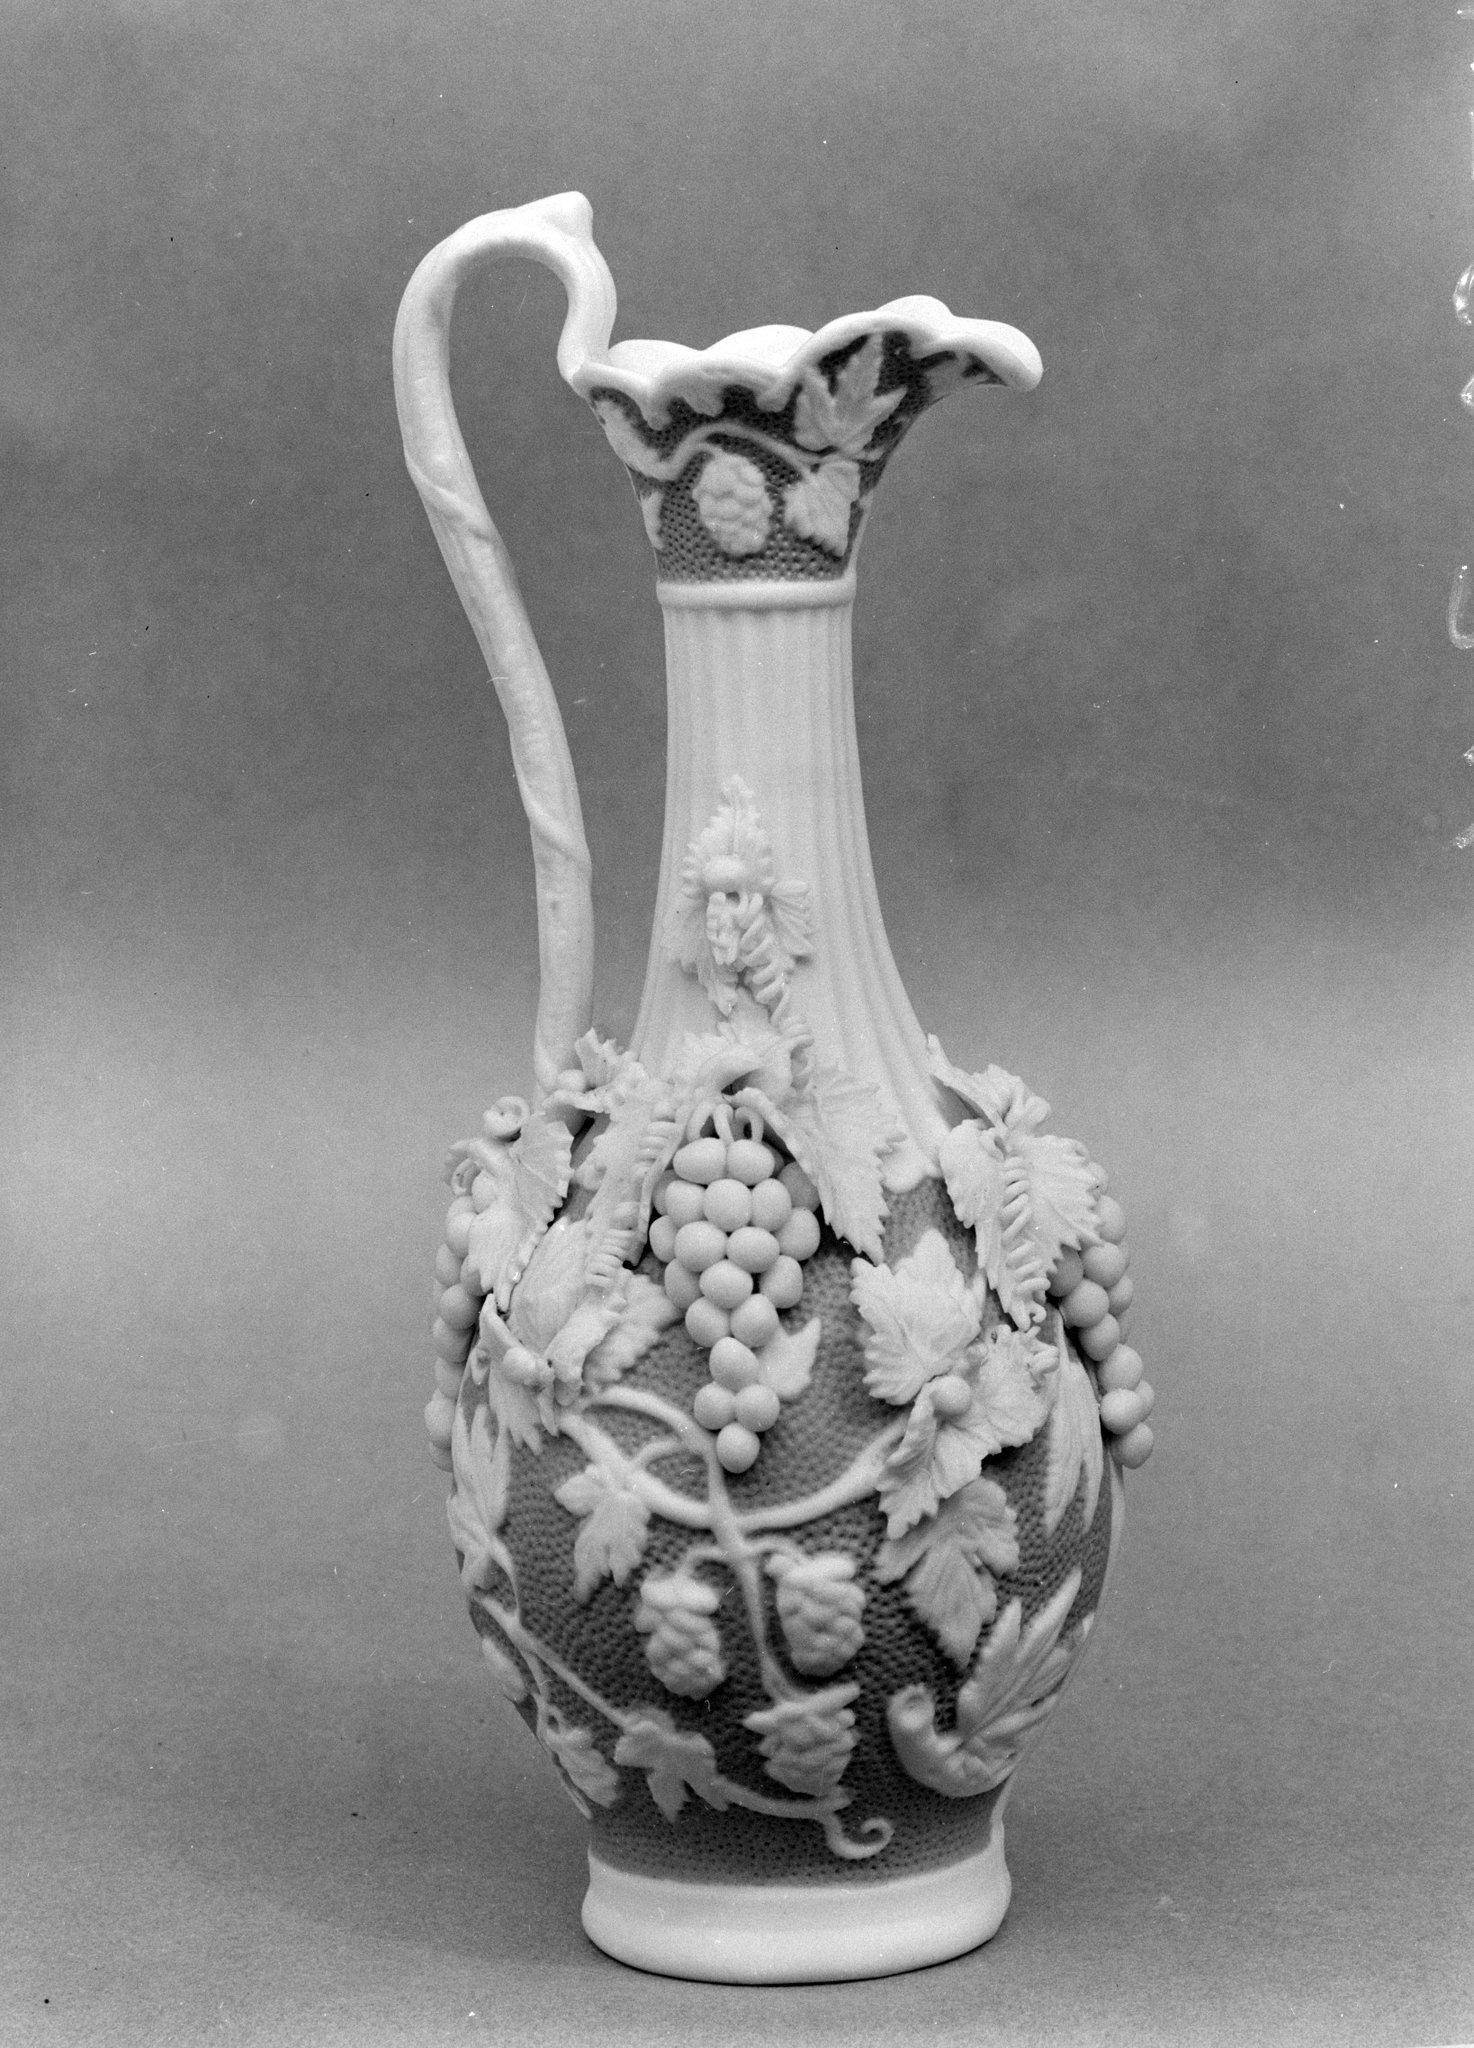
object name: ewer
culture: american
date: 1830-1870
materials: porcelain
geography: united states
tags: grapes,leaves